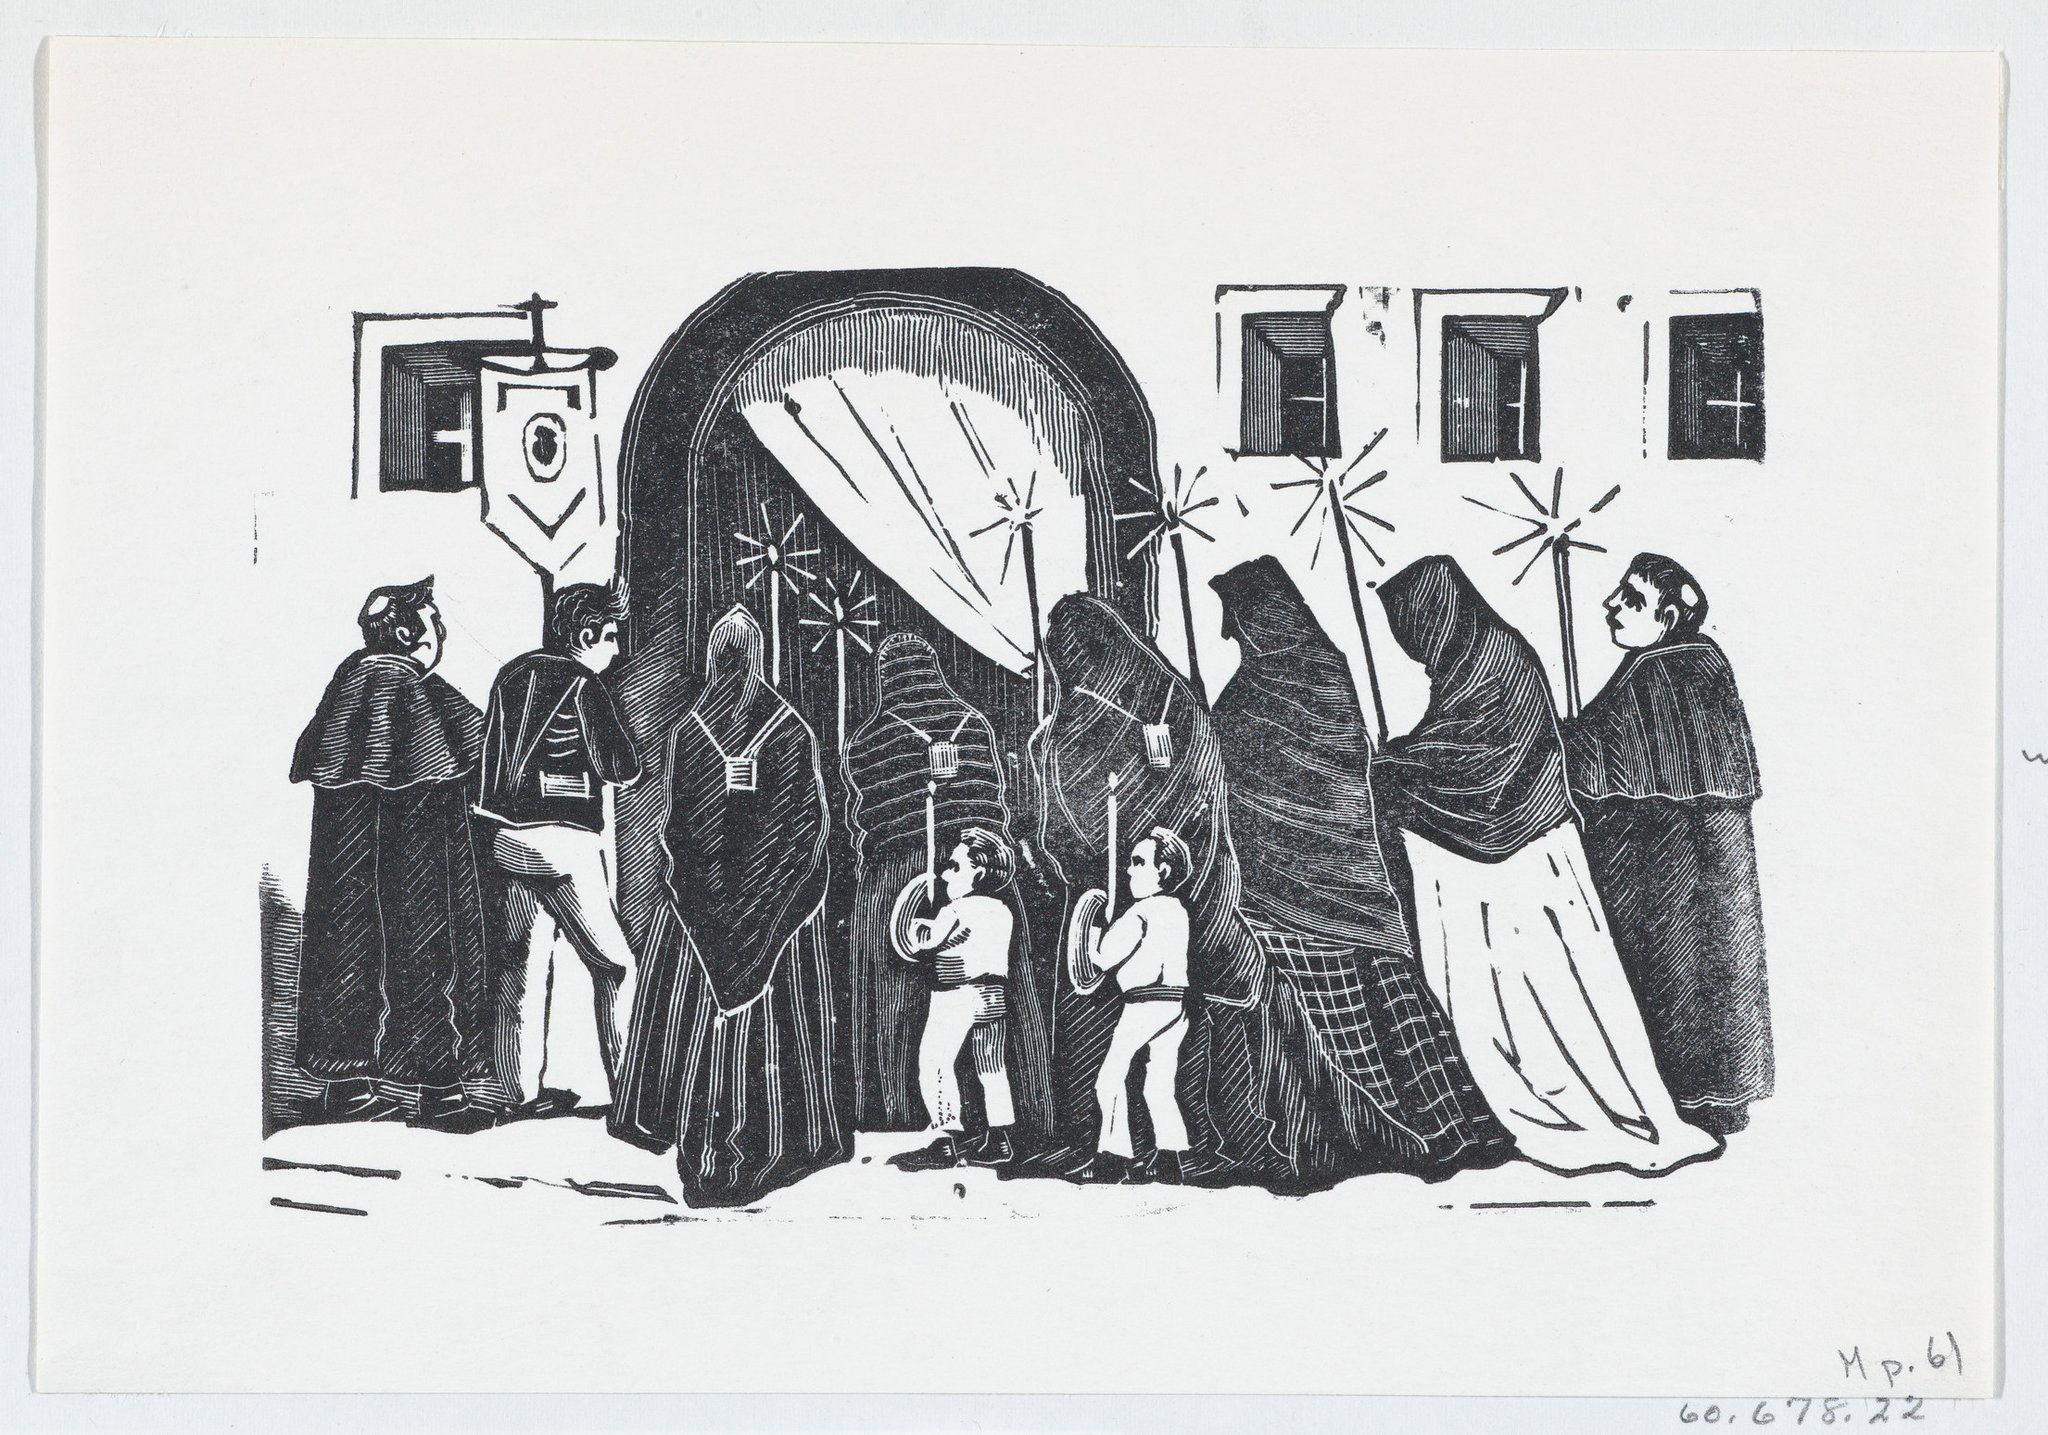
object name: print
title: A holy procession with figures in black cloaks holding candles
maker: josé guadalupe posada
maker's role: artist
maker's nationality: mexican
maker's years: 1852-1913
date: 1880-1910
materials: metal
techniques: engraving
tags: processions